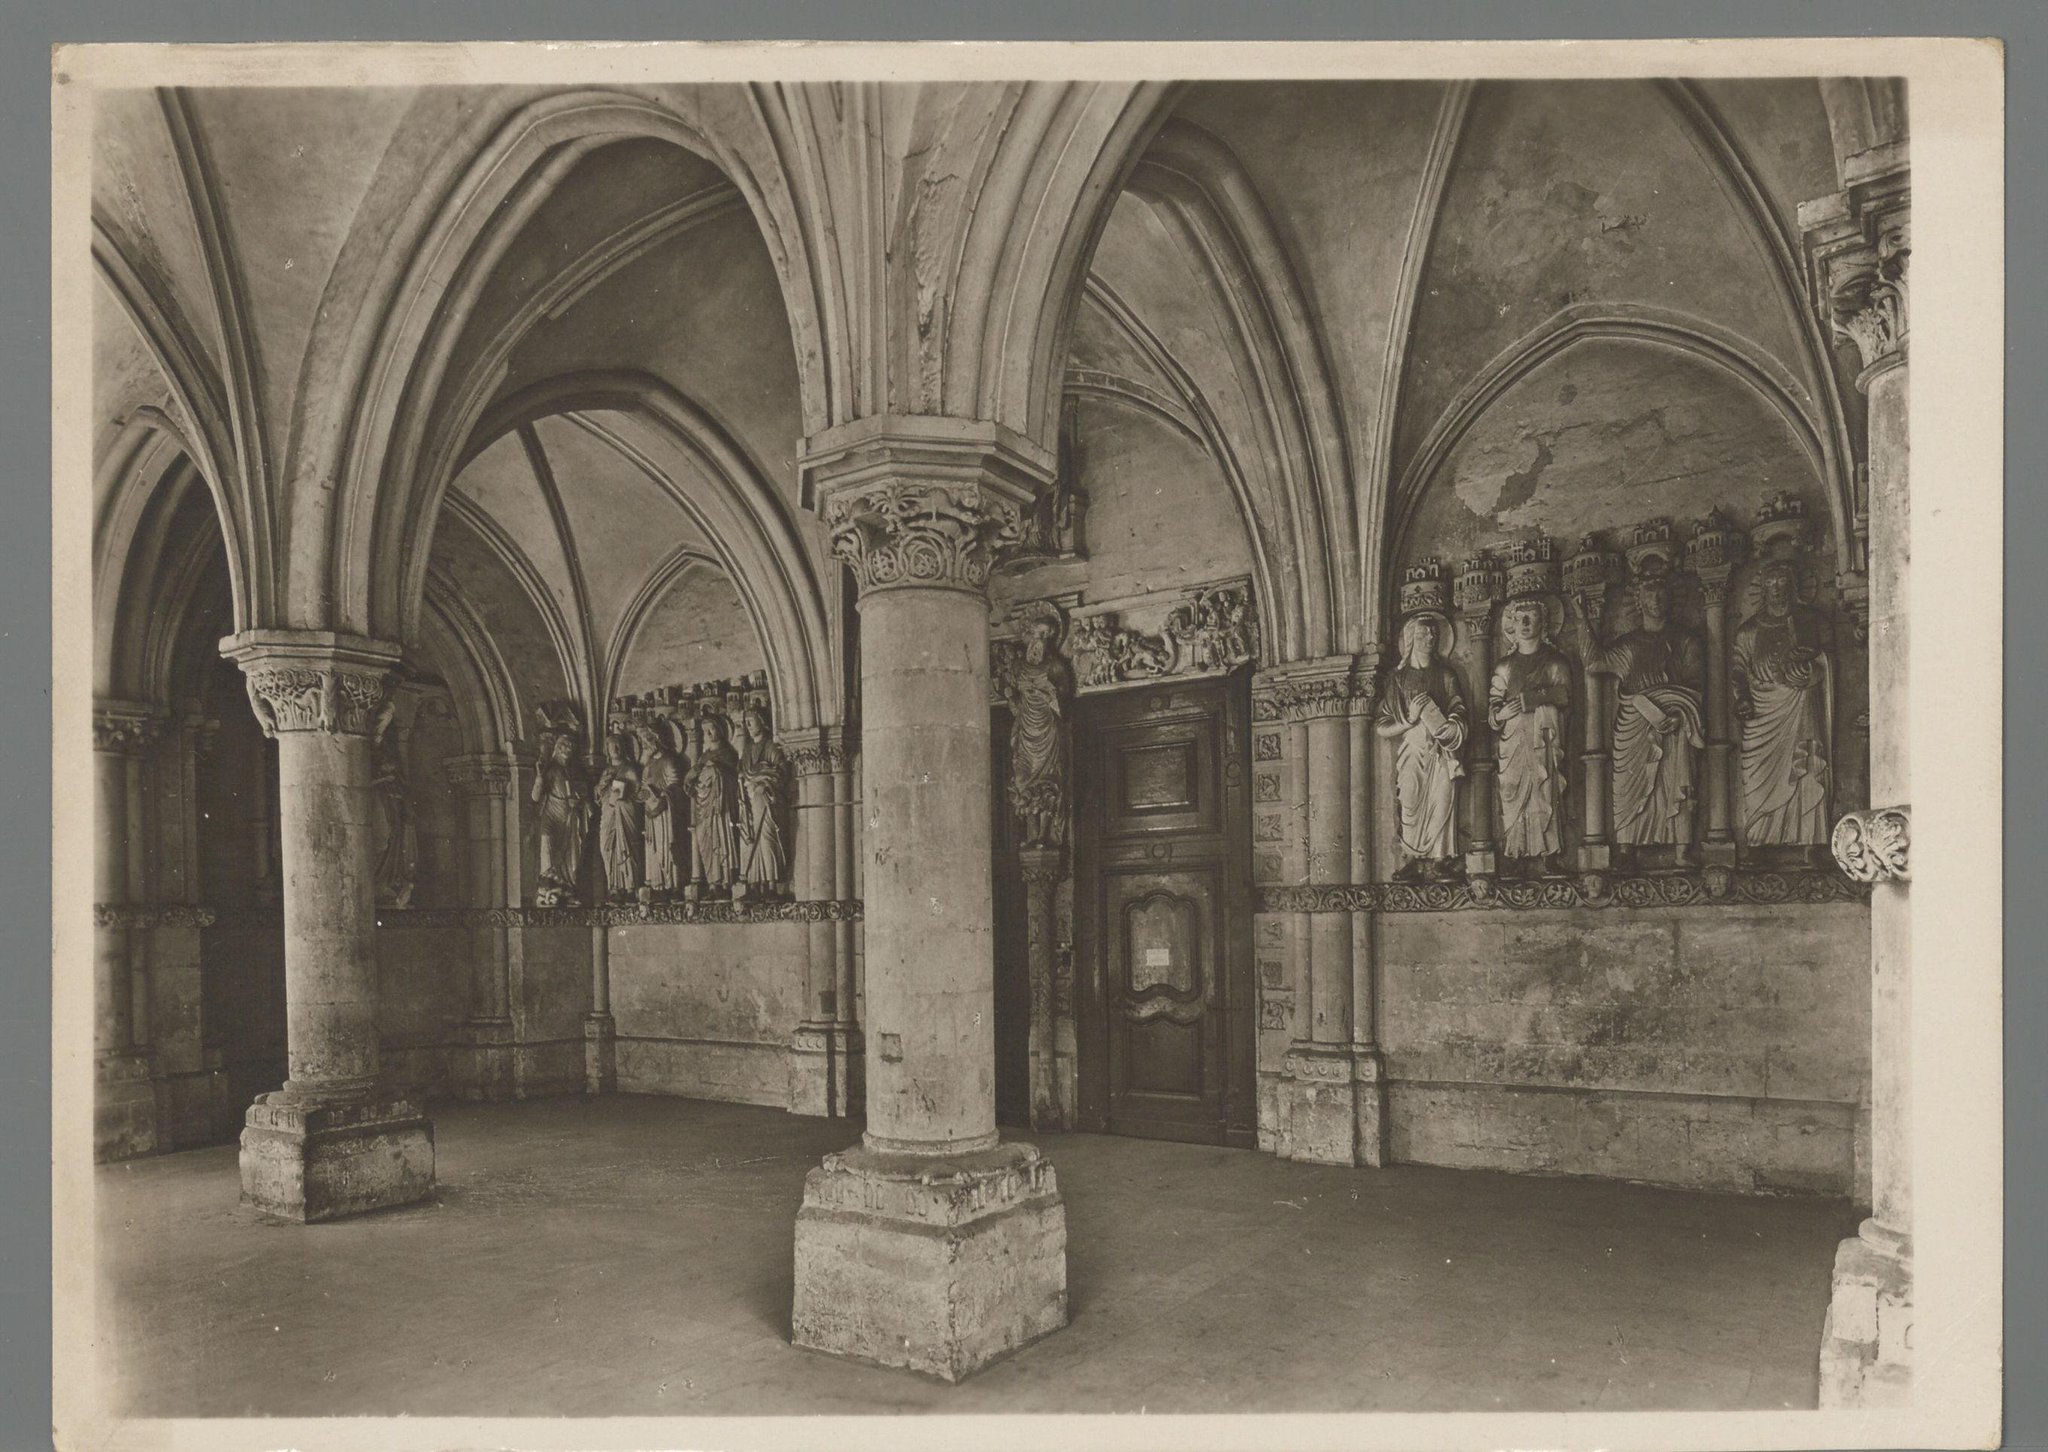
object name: photograph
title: Der Dom zu Münster i. W. Paradies um 1225 mit den 12 Aposteln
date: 1905-1940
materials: photographic support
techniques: gelatin silver print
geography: berlin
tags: interior of church, vault ~ architecture